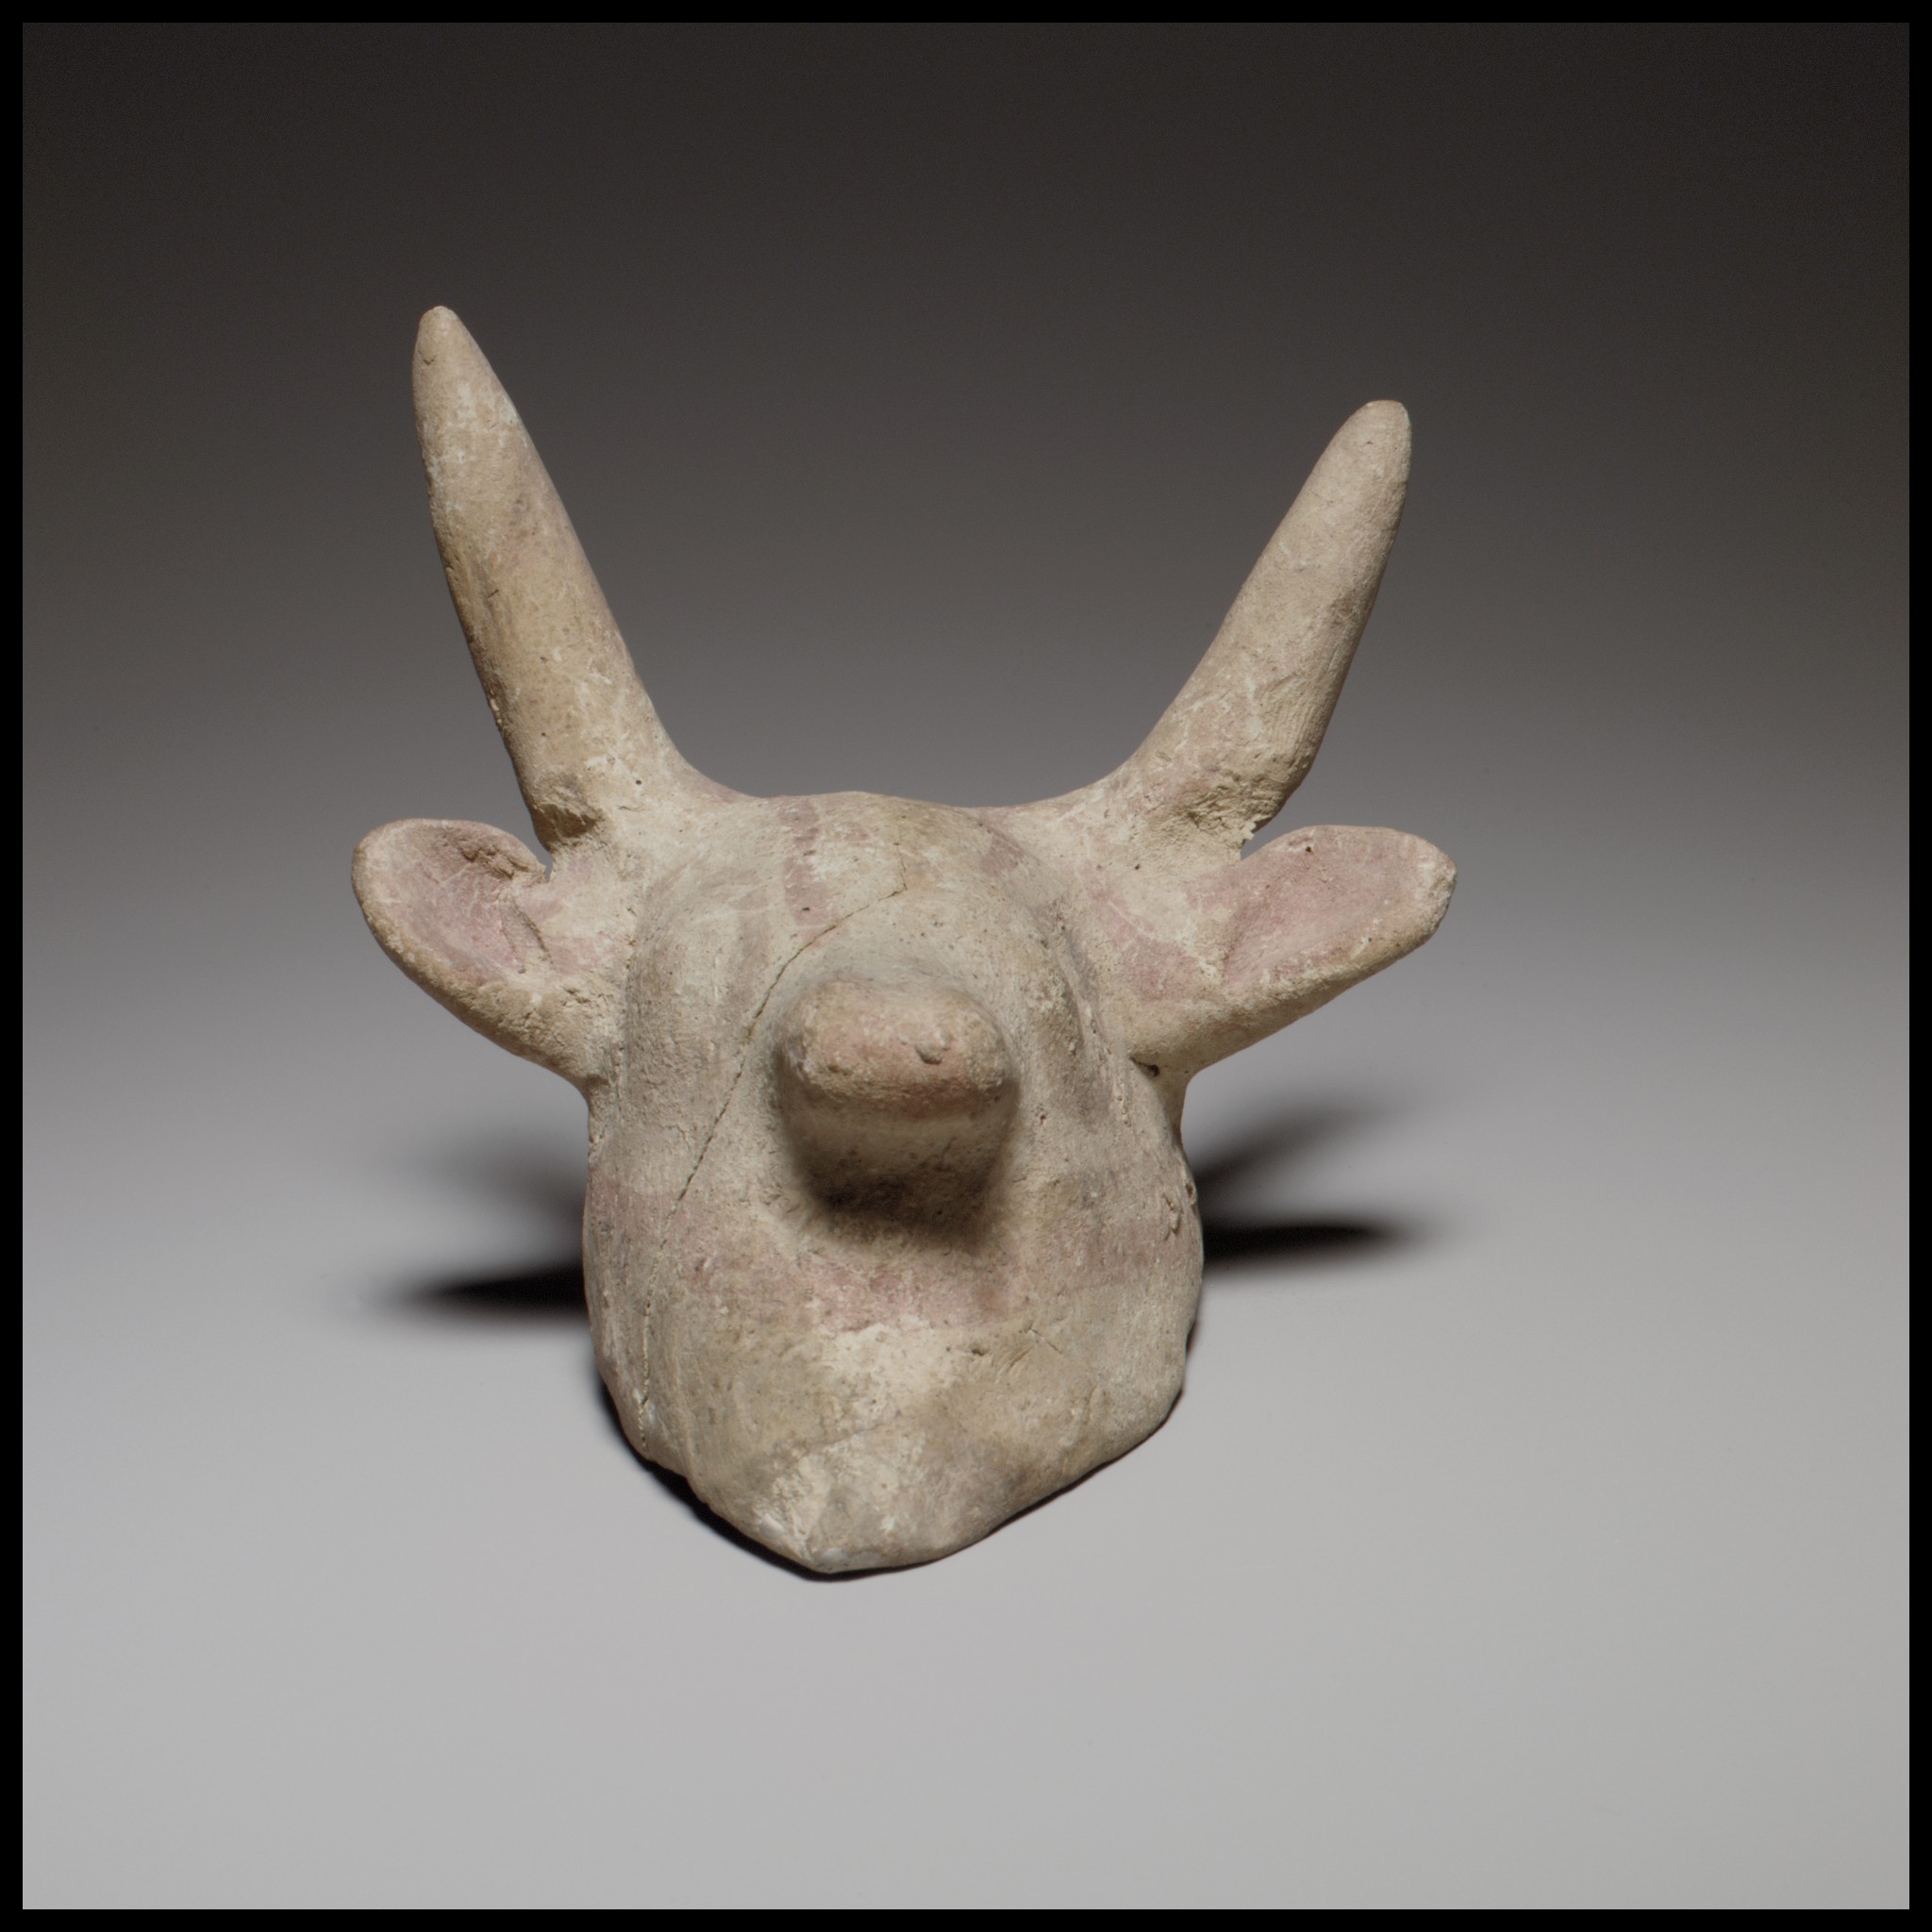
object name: mask of a bull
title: Terracotta mask in the form of a bull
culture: cypriot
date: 600-480 BCE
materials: terracotta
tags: bulls